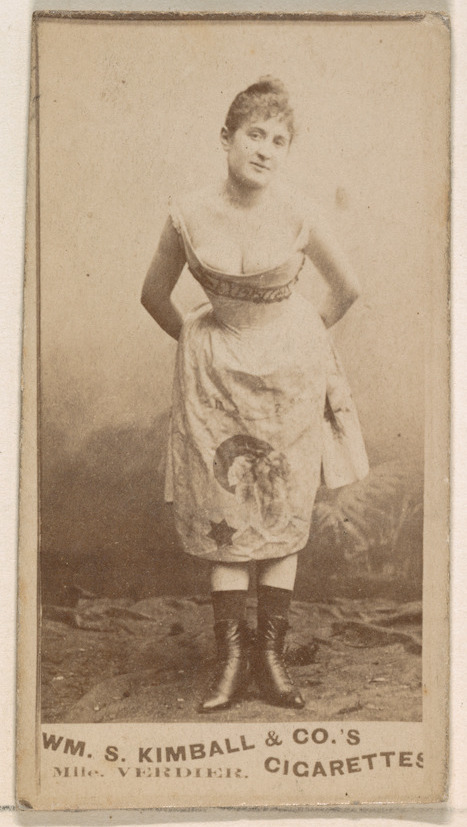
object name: photograph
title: Mlle. Verdier, from the Actresses series (N203) issued by Wm. S. Kimball & Co.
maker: william s. kimball & company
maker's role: publisher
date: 1889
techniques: color lithograph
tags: portraits,women,actresses